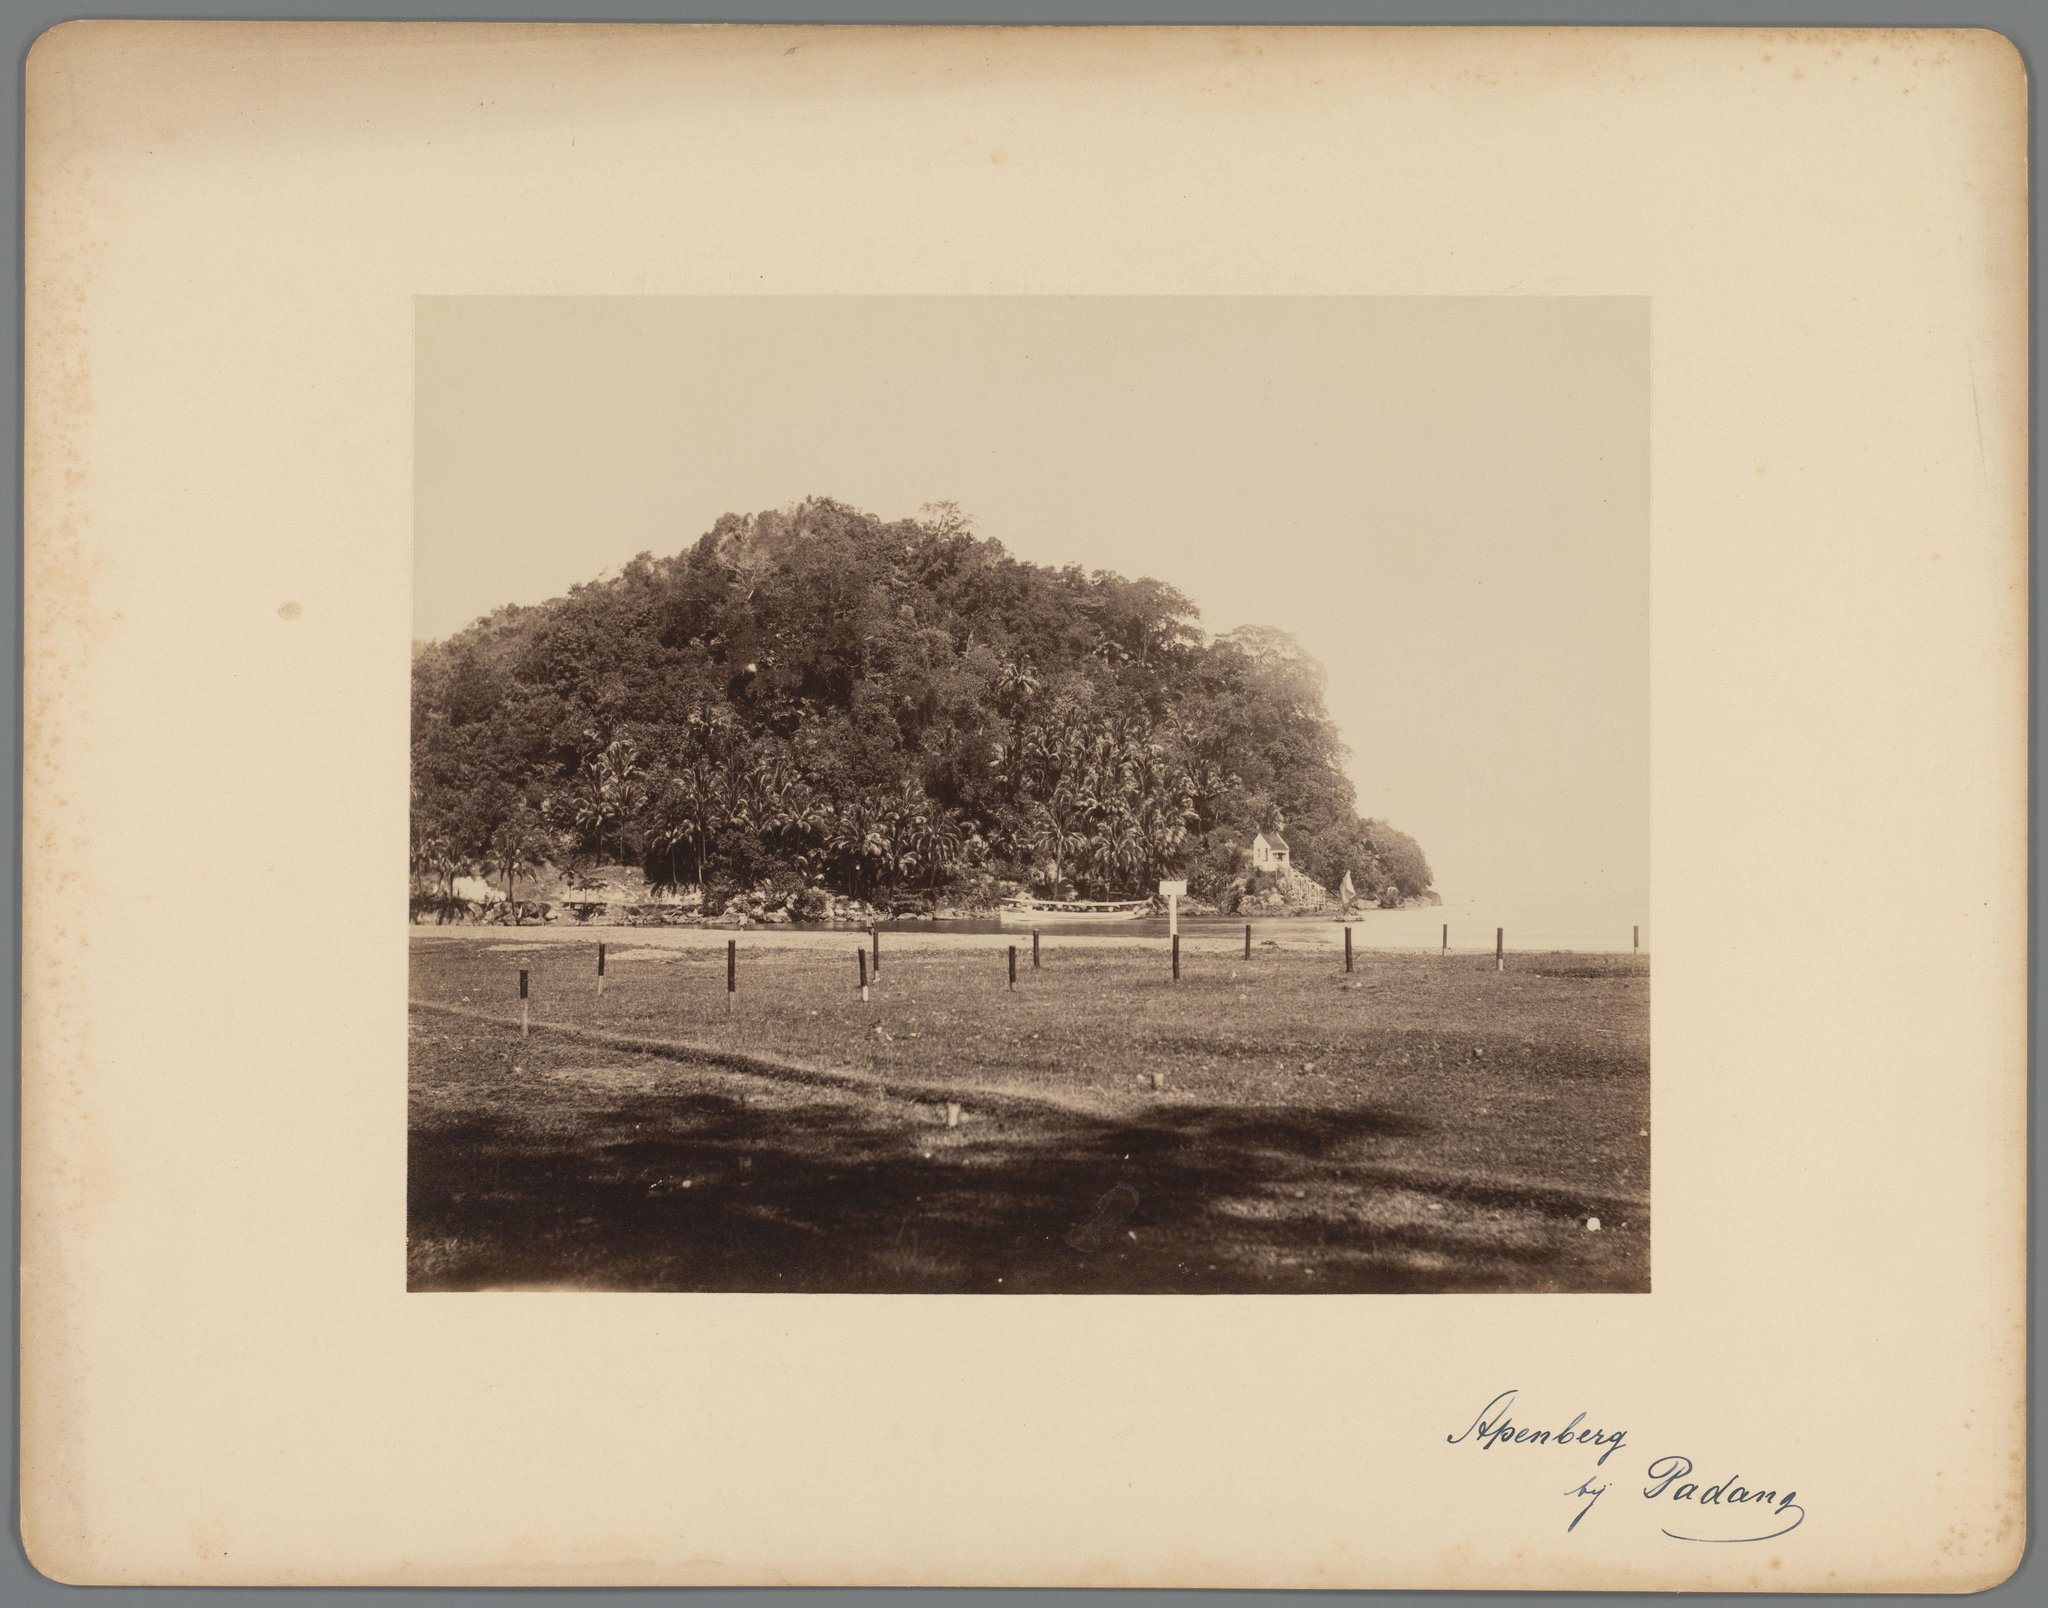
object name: photograph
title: Apenberg bij Padang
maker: christiaan benjamin nieuwenhuis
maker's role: publisher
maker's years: 1863-1922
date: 1891-1895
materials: cardboard, paper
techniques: albumen print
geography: padang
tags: gulf, bay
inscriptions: inscription: ‘Foto’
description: Deze foto zat oorspronkelijk in prentenkabinet RP-F-AA3192.